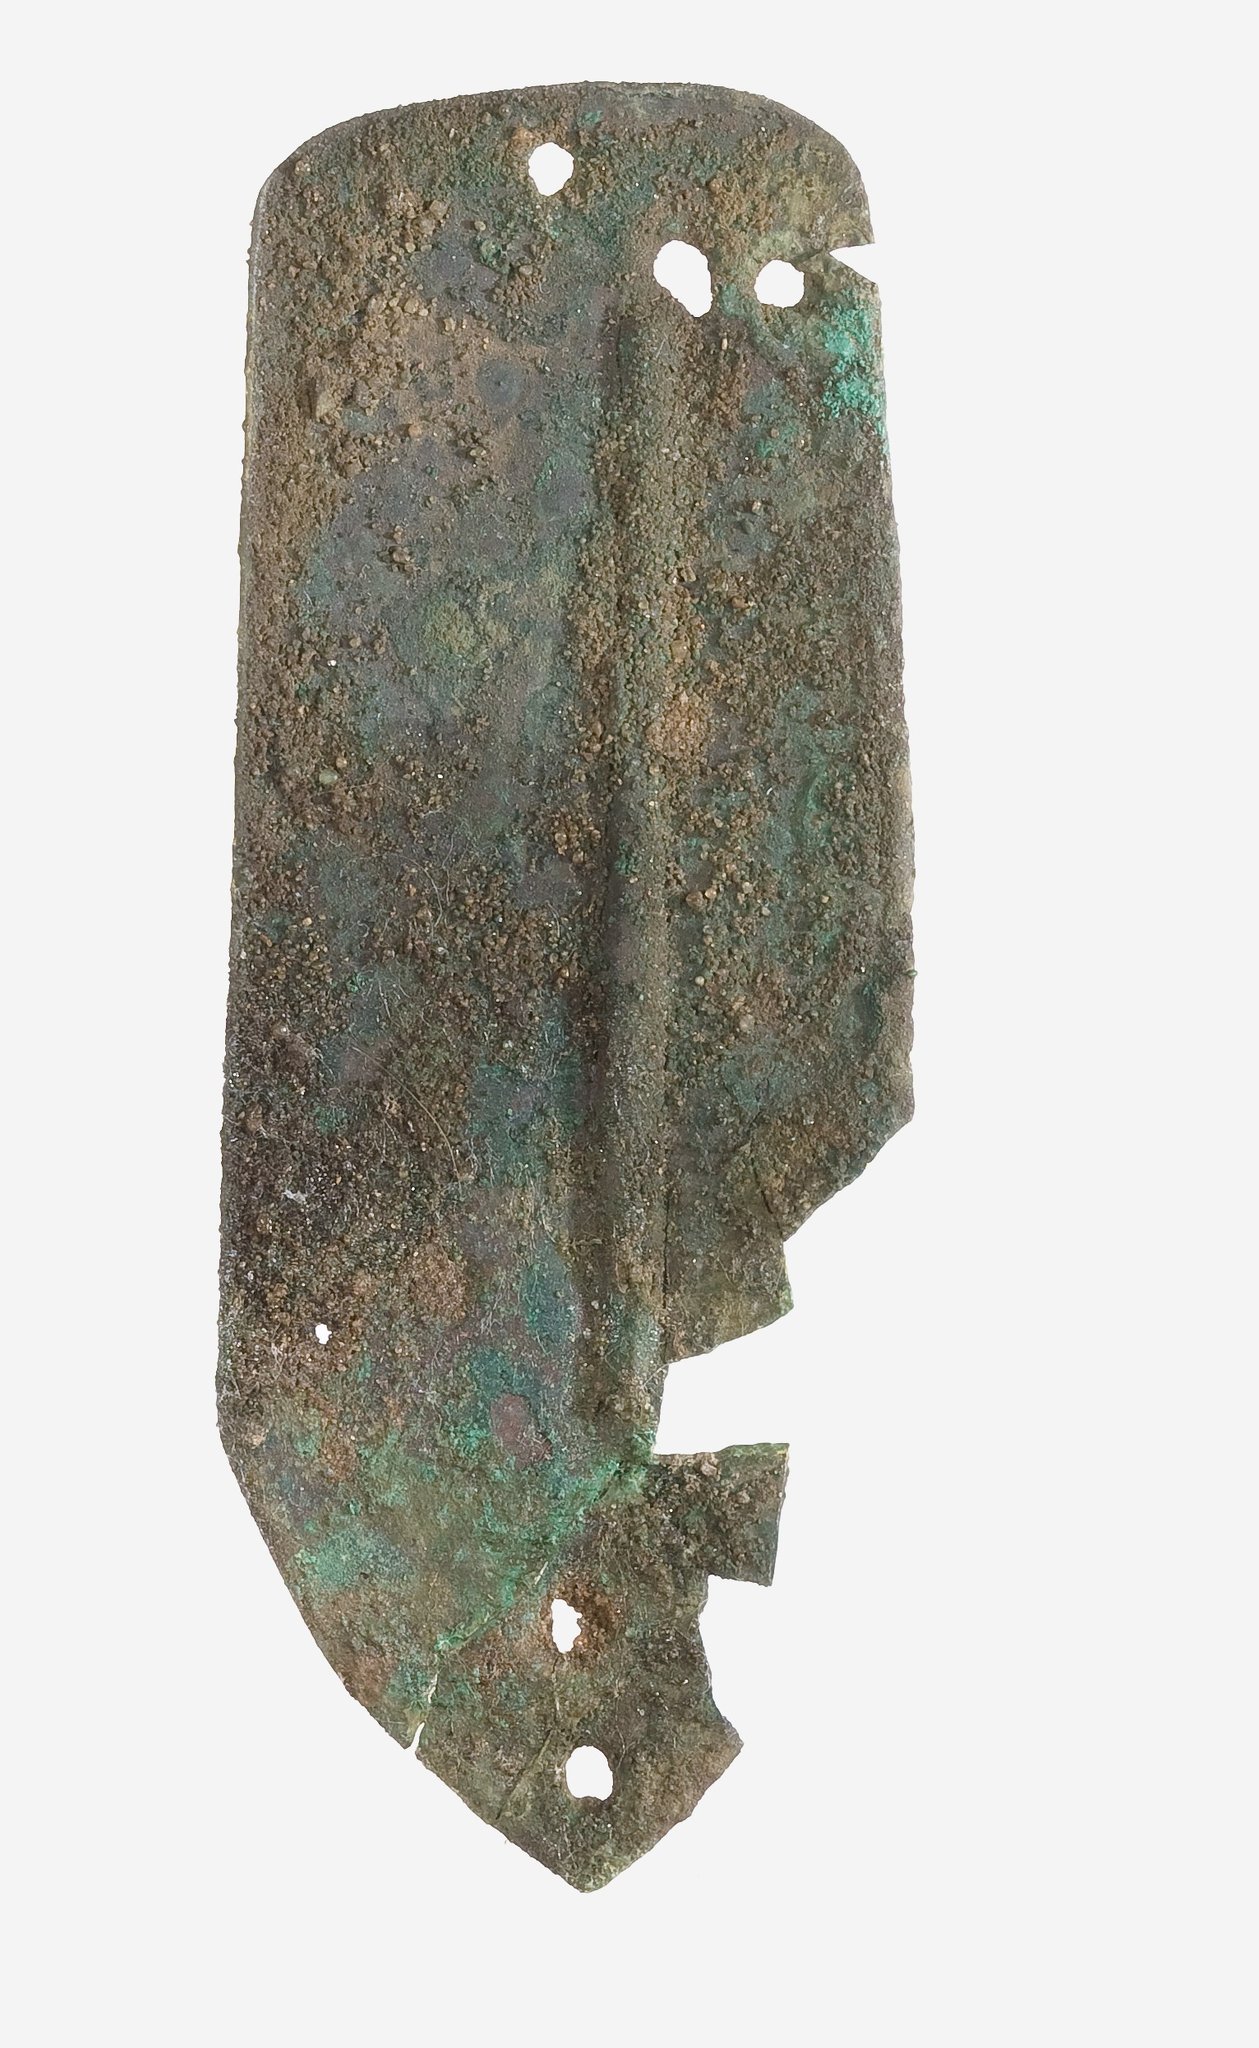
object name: armor scale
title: Scale from Armor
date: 1390-1352 BCE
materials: bronze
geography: egypt